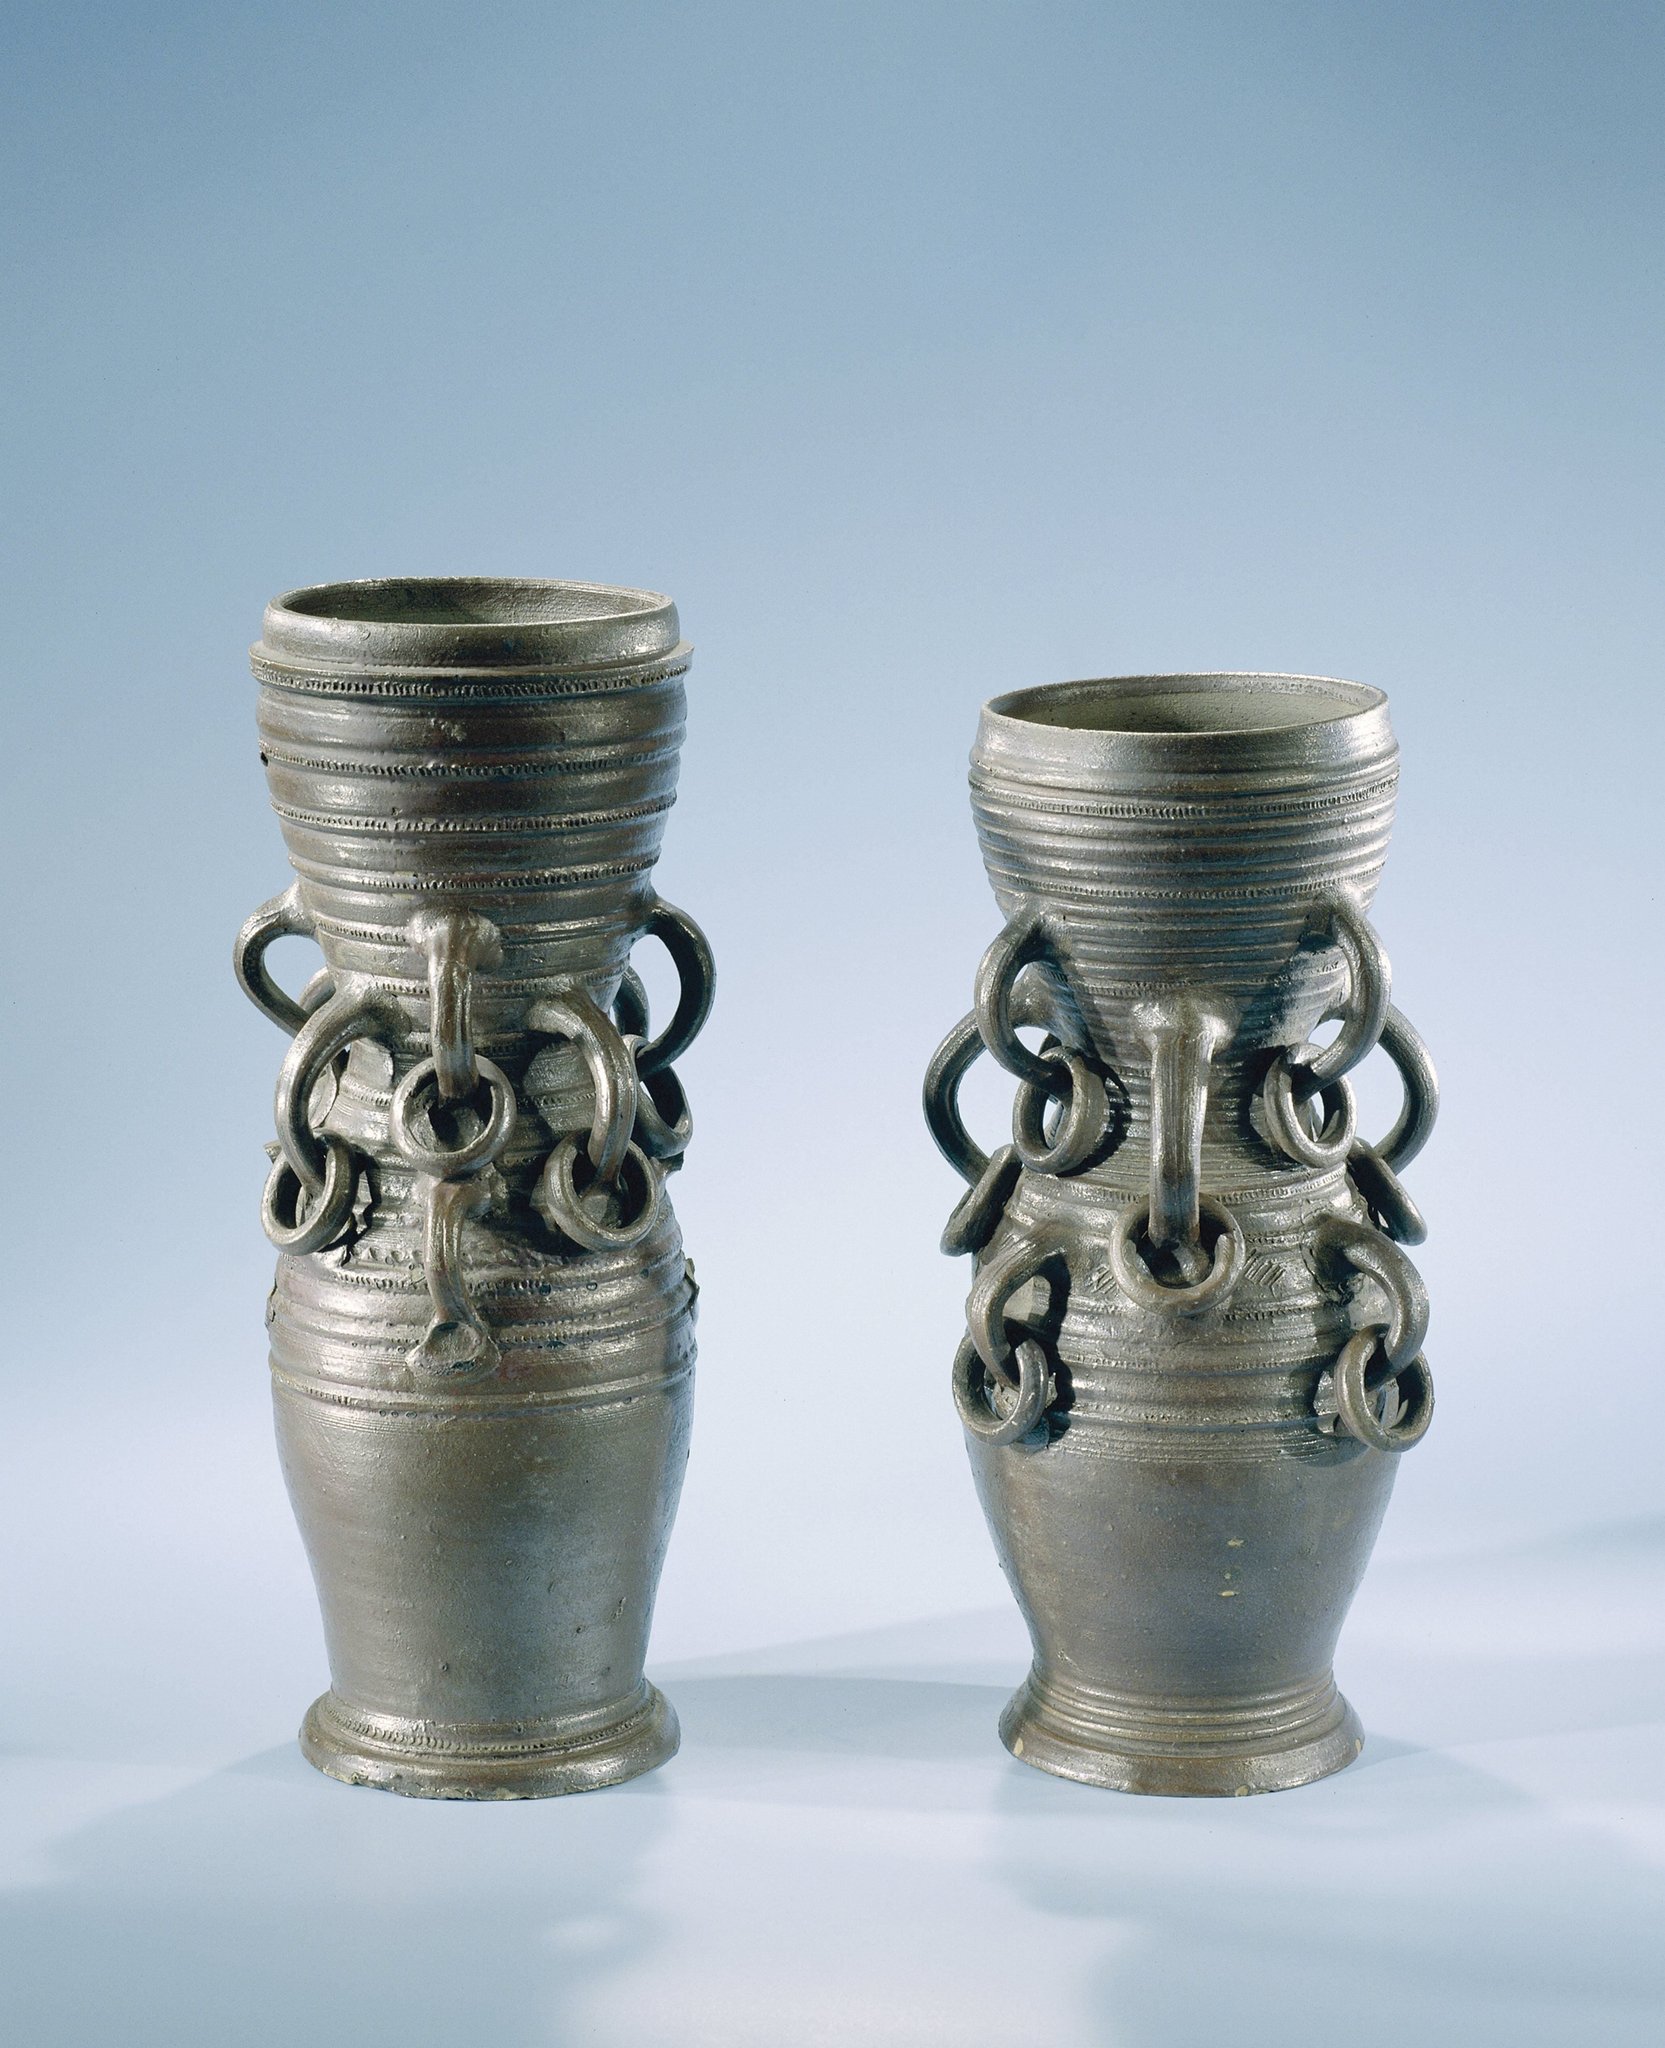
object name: cup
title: Loop-handled beaker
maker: Anonymous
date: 1500-1699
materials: engobe, glaze, stoneware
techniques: firing, forming, turning, vitrification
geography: dreihausen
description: Beker van steengoed op standring met een eivormig lichaam en hoge, trechtervormige nek. Bedekt met een bruine engobe. Vanaf halverwge de buik omhoog versierd met draairingen en op de nek een brede band met kleine oren met elk een ring. Dreihausen.